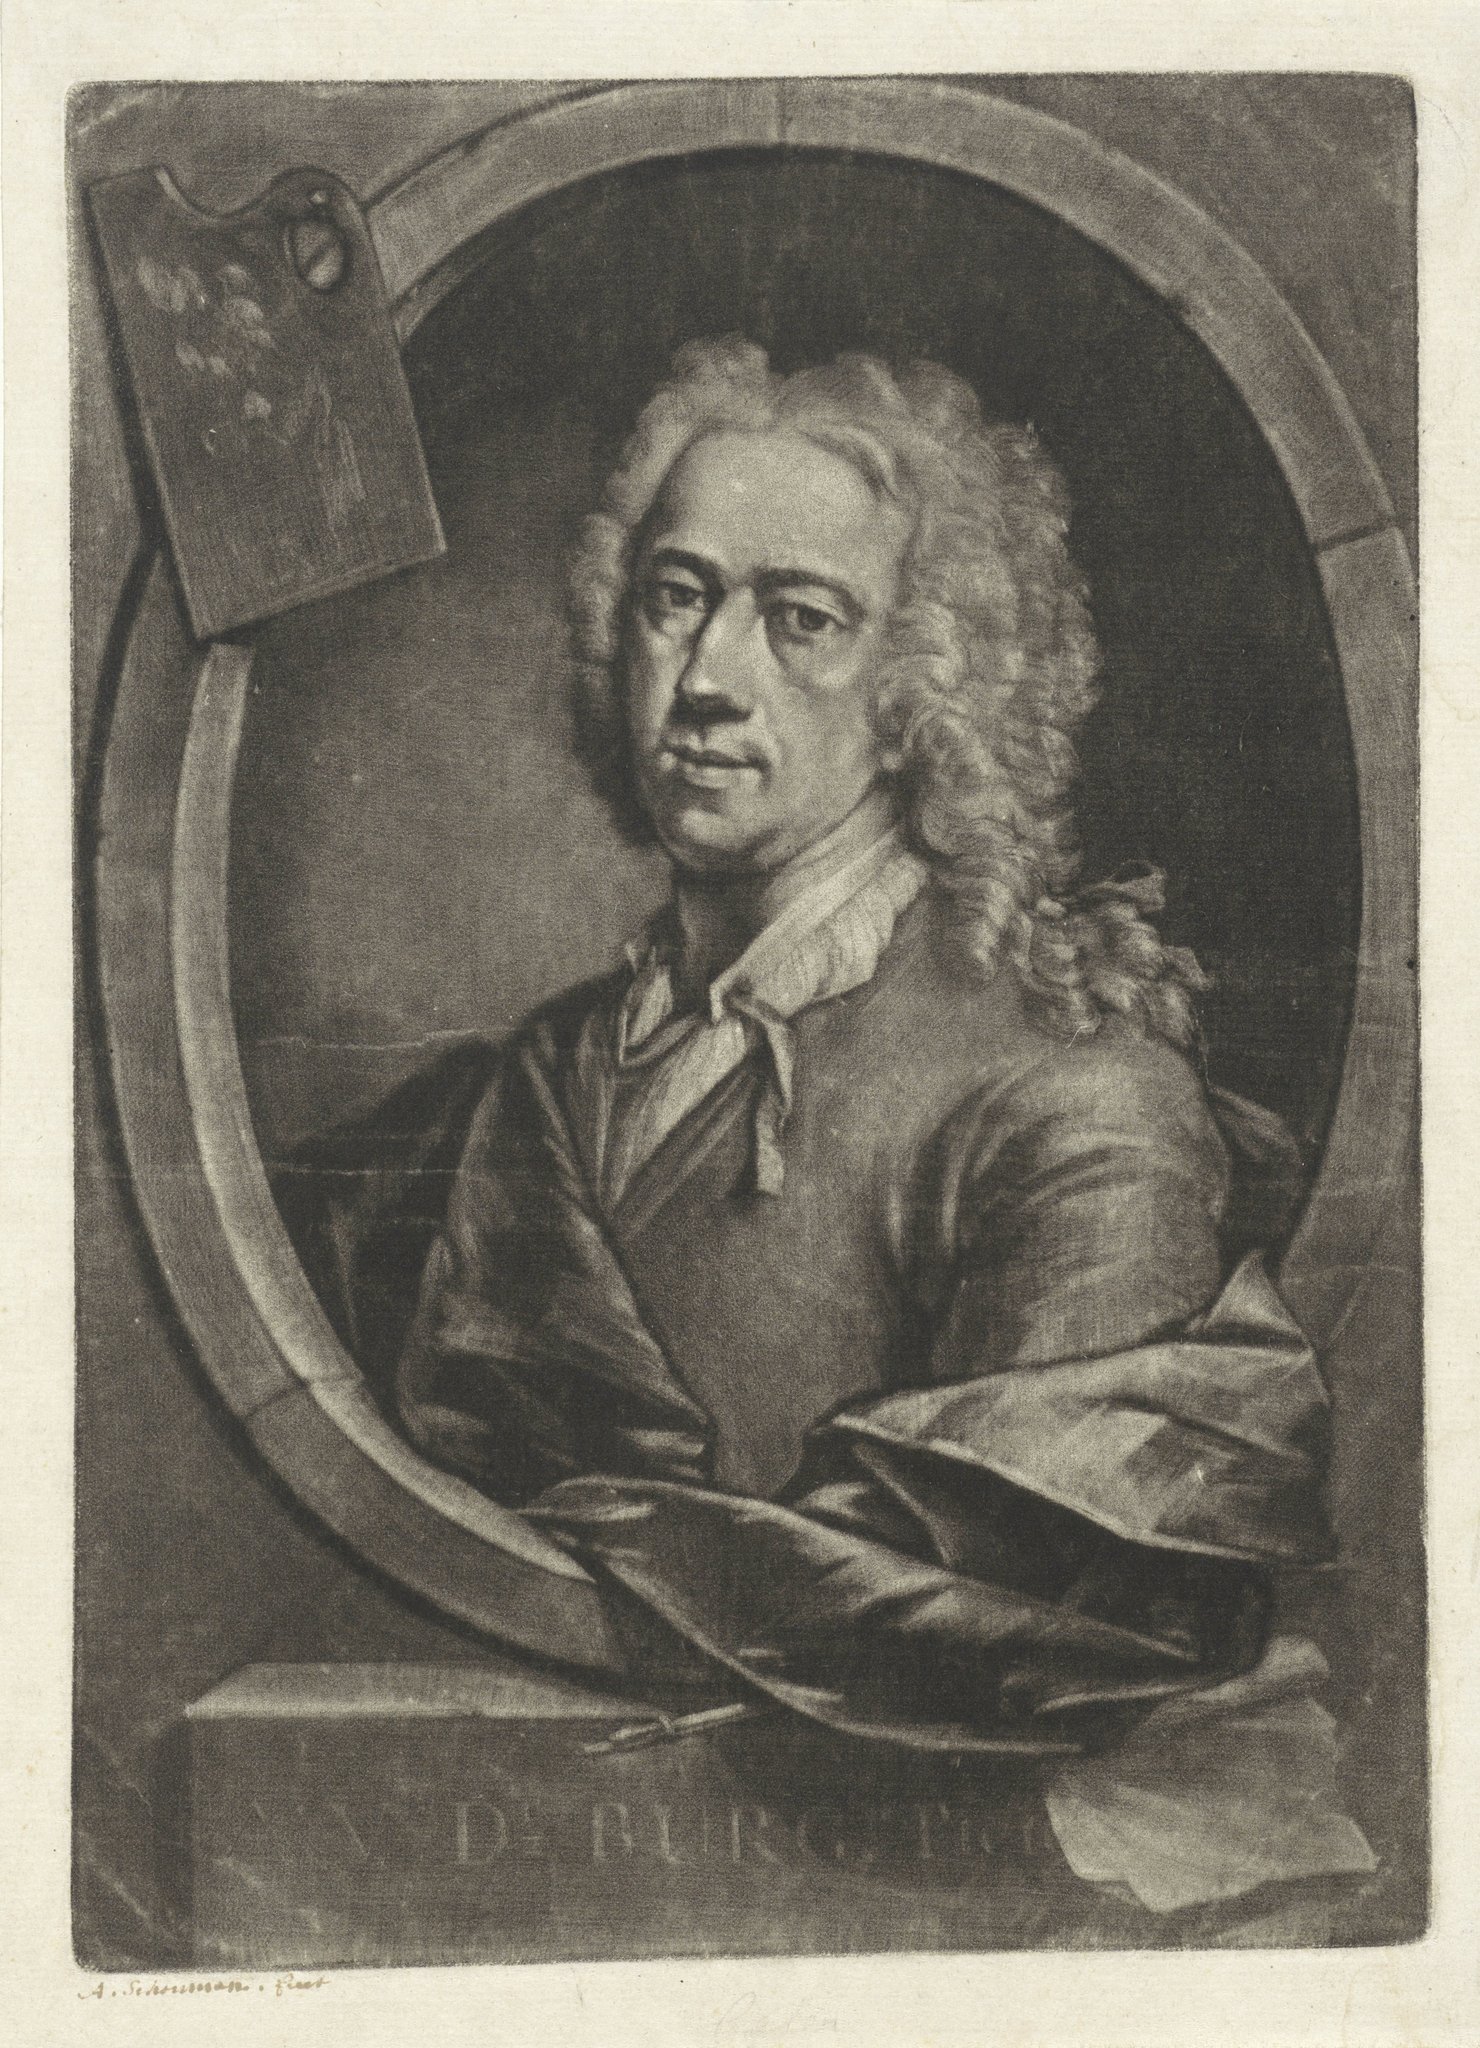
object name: print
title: Zelfportret van Adriaan van der Burg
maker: aert schouman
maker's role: draughtsman, painter, print maker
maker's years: 1710-1792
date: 1730-1792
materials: paper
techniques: mezzotint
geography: dordrecht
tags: dordrecht, painter, adriaan van der burg, portrait, self-portrait of painter, tools, implements of painter, palette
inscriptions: collector's mark: Lugt 2228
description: De kunstschilder Adriaan van der Burg. De omlijsting is versierd met een palet en een penseel.